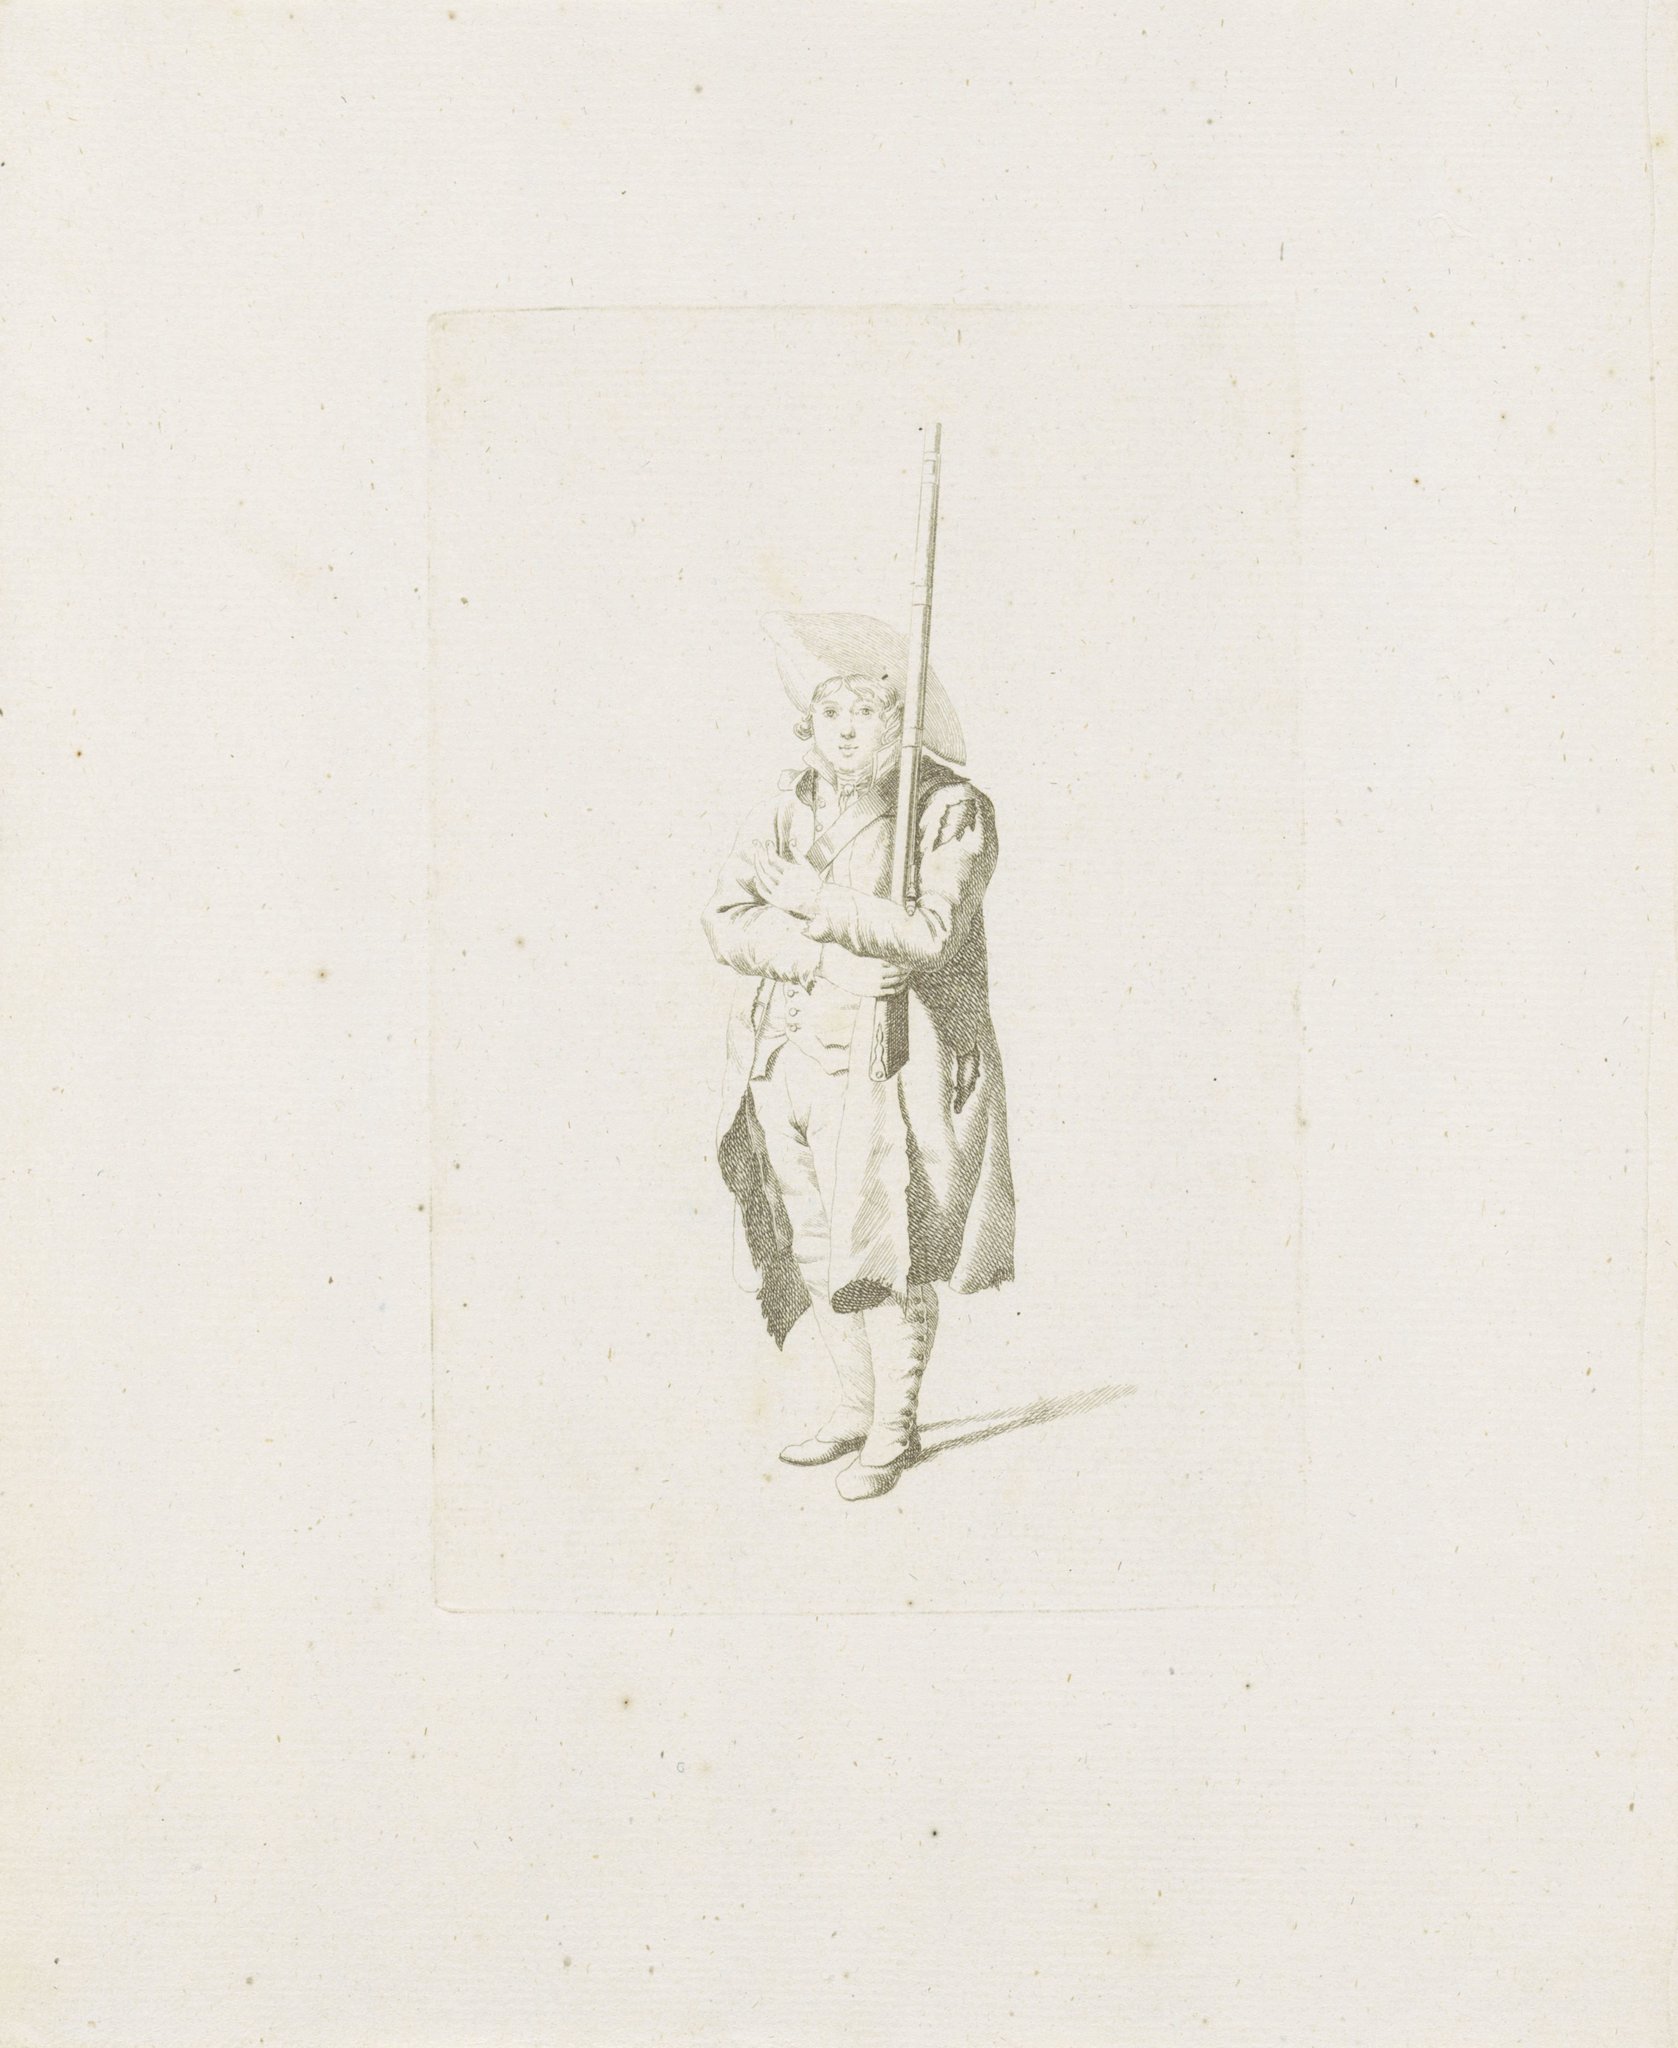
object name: print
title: Franse infantrie in Nederland in 1795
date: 1795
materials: paper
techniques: engraving, etching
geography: northern netherlands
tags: (military) uniforms (+ infantry), clothes, costume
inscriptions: collector's mark: Lugt 2228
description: Een staande Franse soldaat. Onderdeel van een serie van vijftien platen van Franse infanterie, vooral soldaten en enkele officieren, in ongeregelde uniform of kleding, zoals deze in 1795 in de Republiek aankwam.